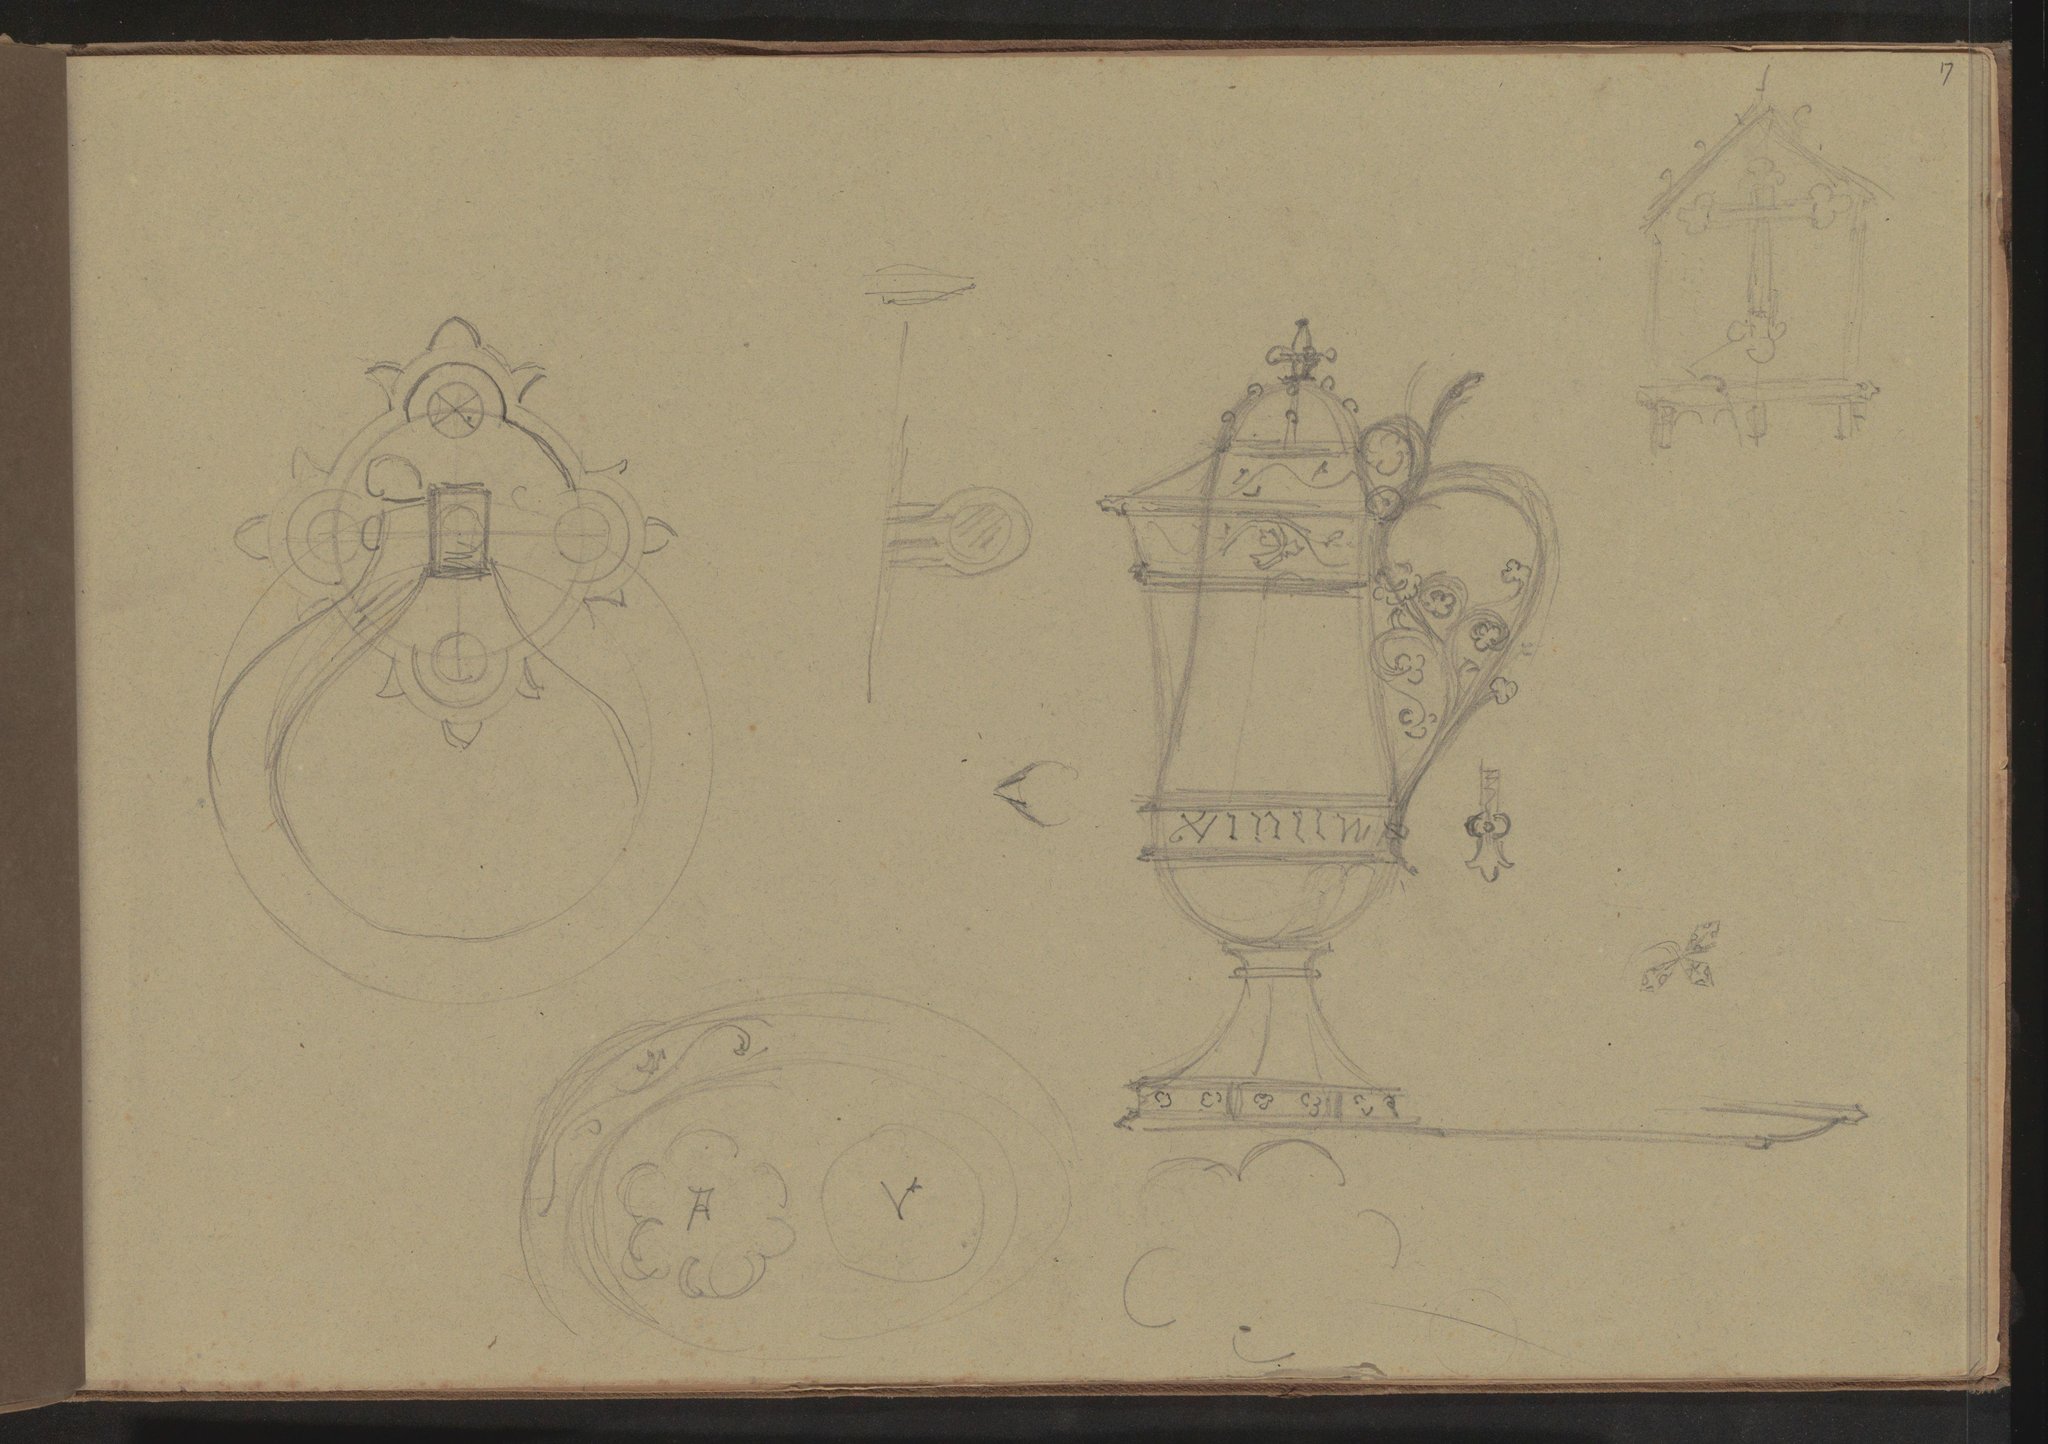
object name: sketchbook leaf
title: Studieblad, onder andere met een kelk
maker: pierre joseph hubert cuypers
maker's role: draughtsman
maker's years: 1827-1921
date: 1837-1921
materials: paper, pencil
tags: chalice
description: Blad 17 recto uit een schetsboek met 23 bladen.